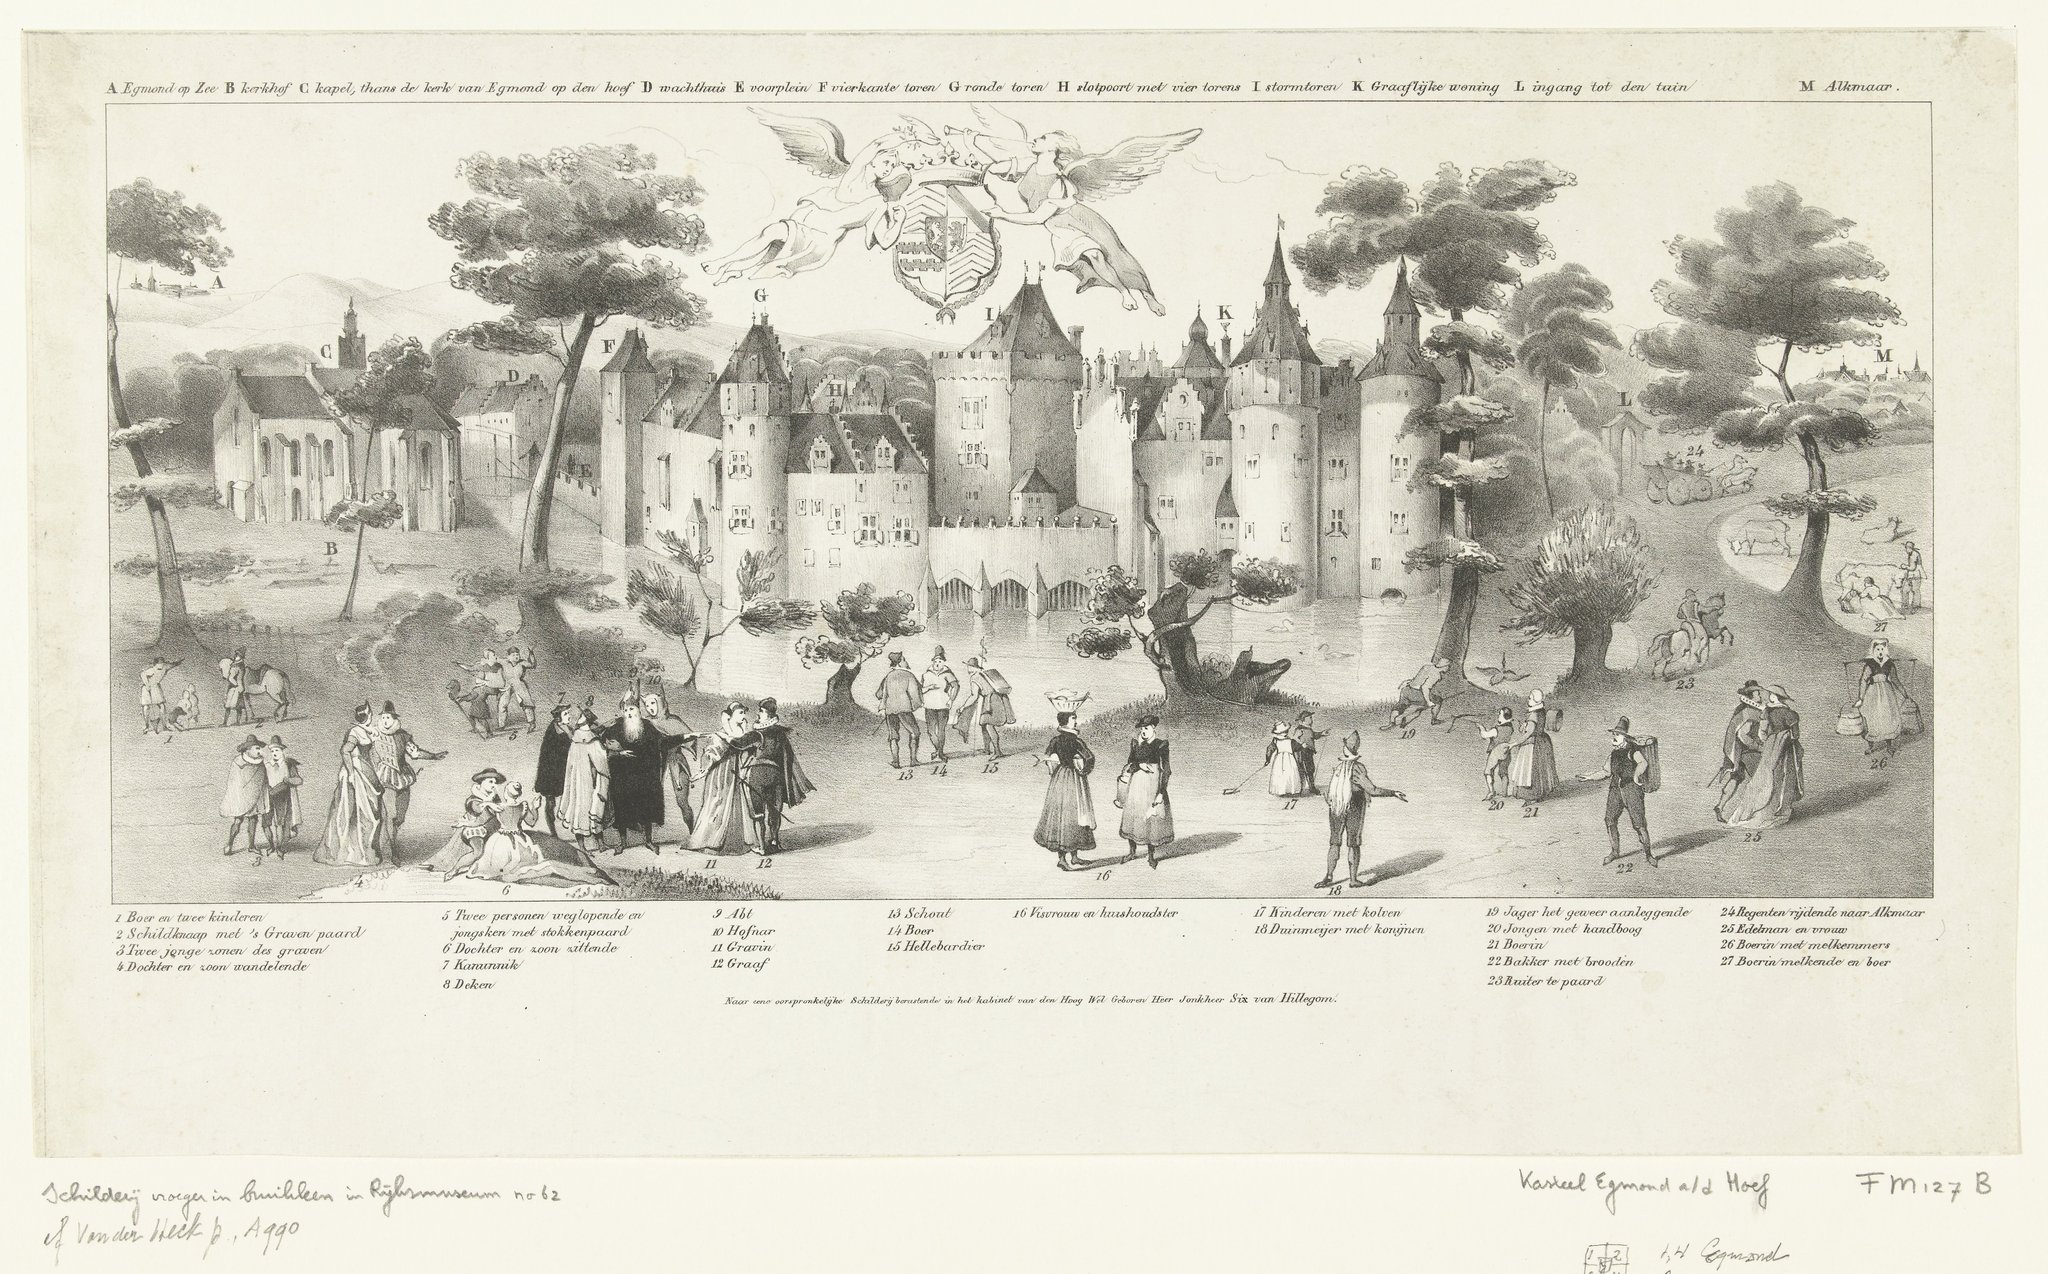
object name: print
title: Kasteel van Egmond (Egmond aan den Hoef), 11e eeuw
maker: Anonymous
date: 1800-1899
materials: paper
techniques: lithograph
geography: netherlands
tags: castle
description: Kasteel Egmond aan den Hoef, het Hof van Egmond in welstand, rondom door water omsingeld. Links in de verte het dorp Egmond aan Zee, rechts Alkmaar. Op de voorgrond voorbeelden van mensen van allerlei rangen en standen. In de lucht twee engelen met een wapen. Onder en boven de legenda. Naar een schilderij in de collectie Six van Hillegrom, vroeger in bruikleen in het Rijksmuseum (no. 62).